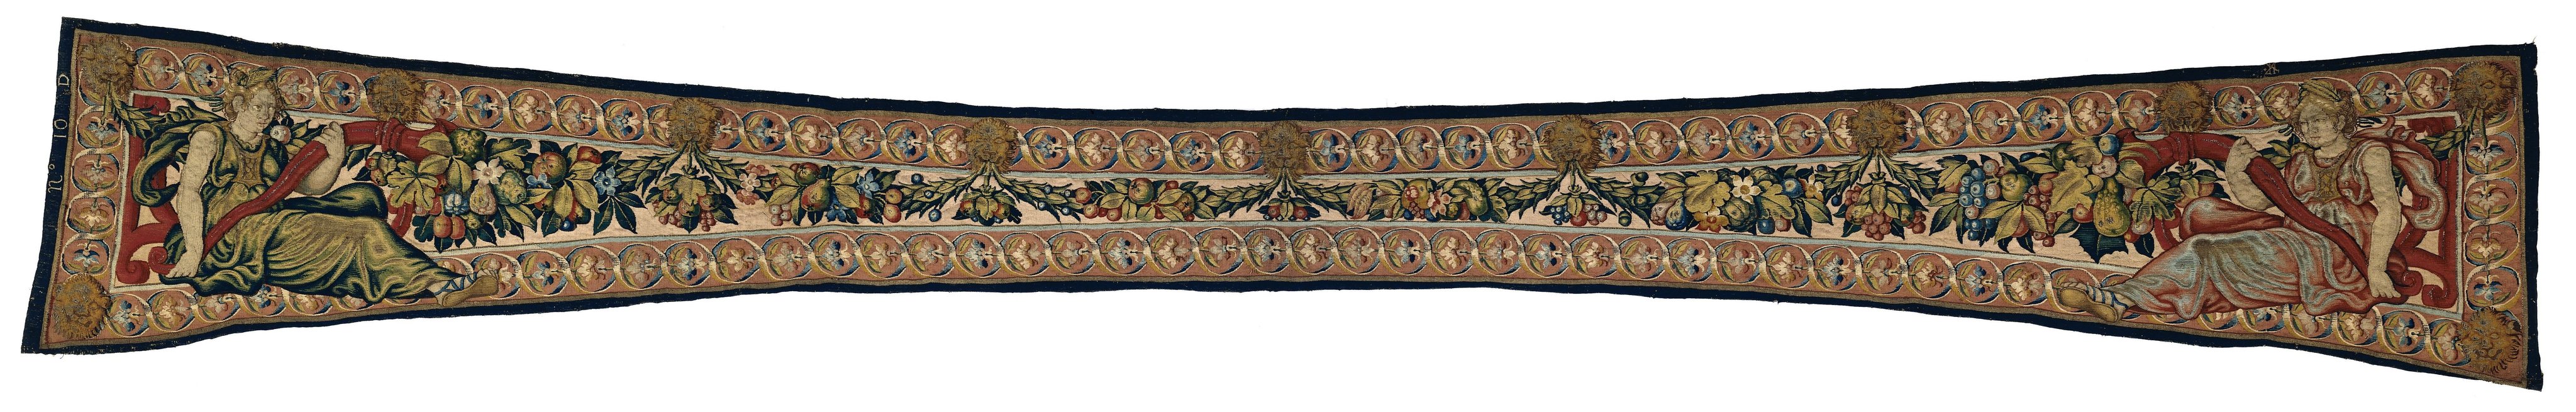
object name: tapestry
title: Boogvormig groteskentapijt met allegorische figuren met hoornen des overvloeds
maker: meester van het geometrische merk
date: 1560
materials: metal thread, silk, wool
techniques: tapestry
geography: brussels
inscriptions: mark: ‘no. 10 D’, mark: ‘Merk van de Meester van het Geometrische Merk’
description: Boogvormig tapisserie voor boven een raamnis, uit de serie Grotesken van Sigismund August van Polen. Boven- en zijkanten recht, onderkant holvormig afgesneden. Op het middenfond zijn festoenen van bloemen en vruchten gehangen aan leeuwenmaskers. De hoekfestoenen komen uit hoorns van overvloed, opgehouden door een zittende vrouw. Linkd ingeweven "no 10 D', rechts in de bovenrand een weversmerk.